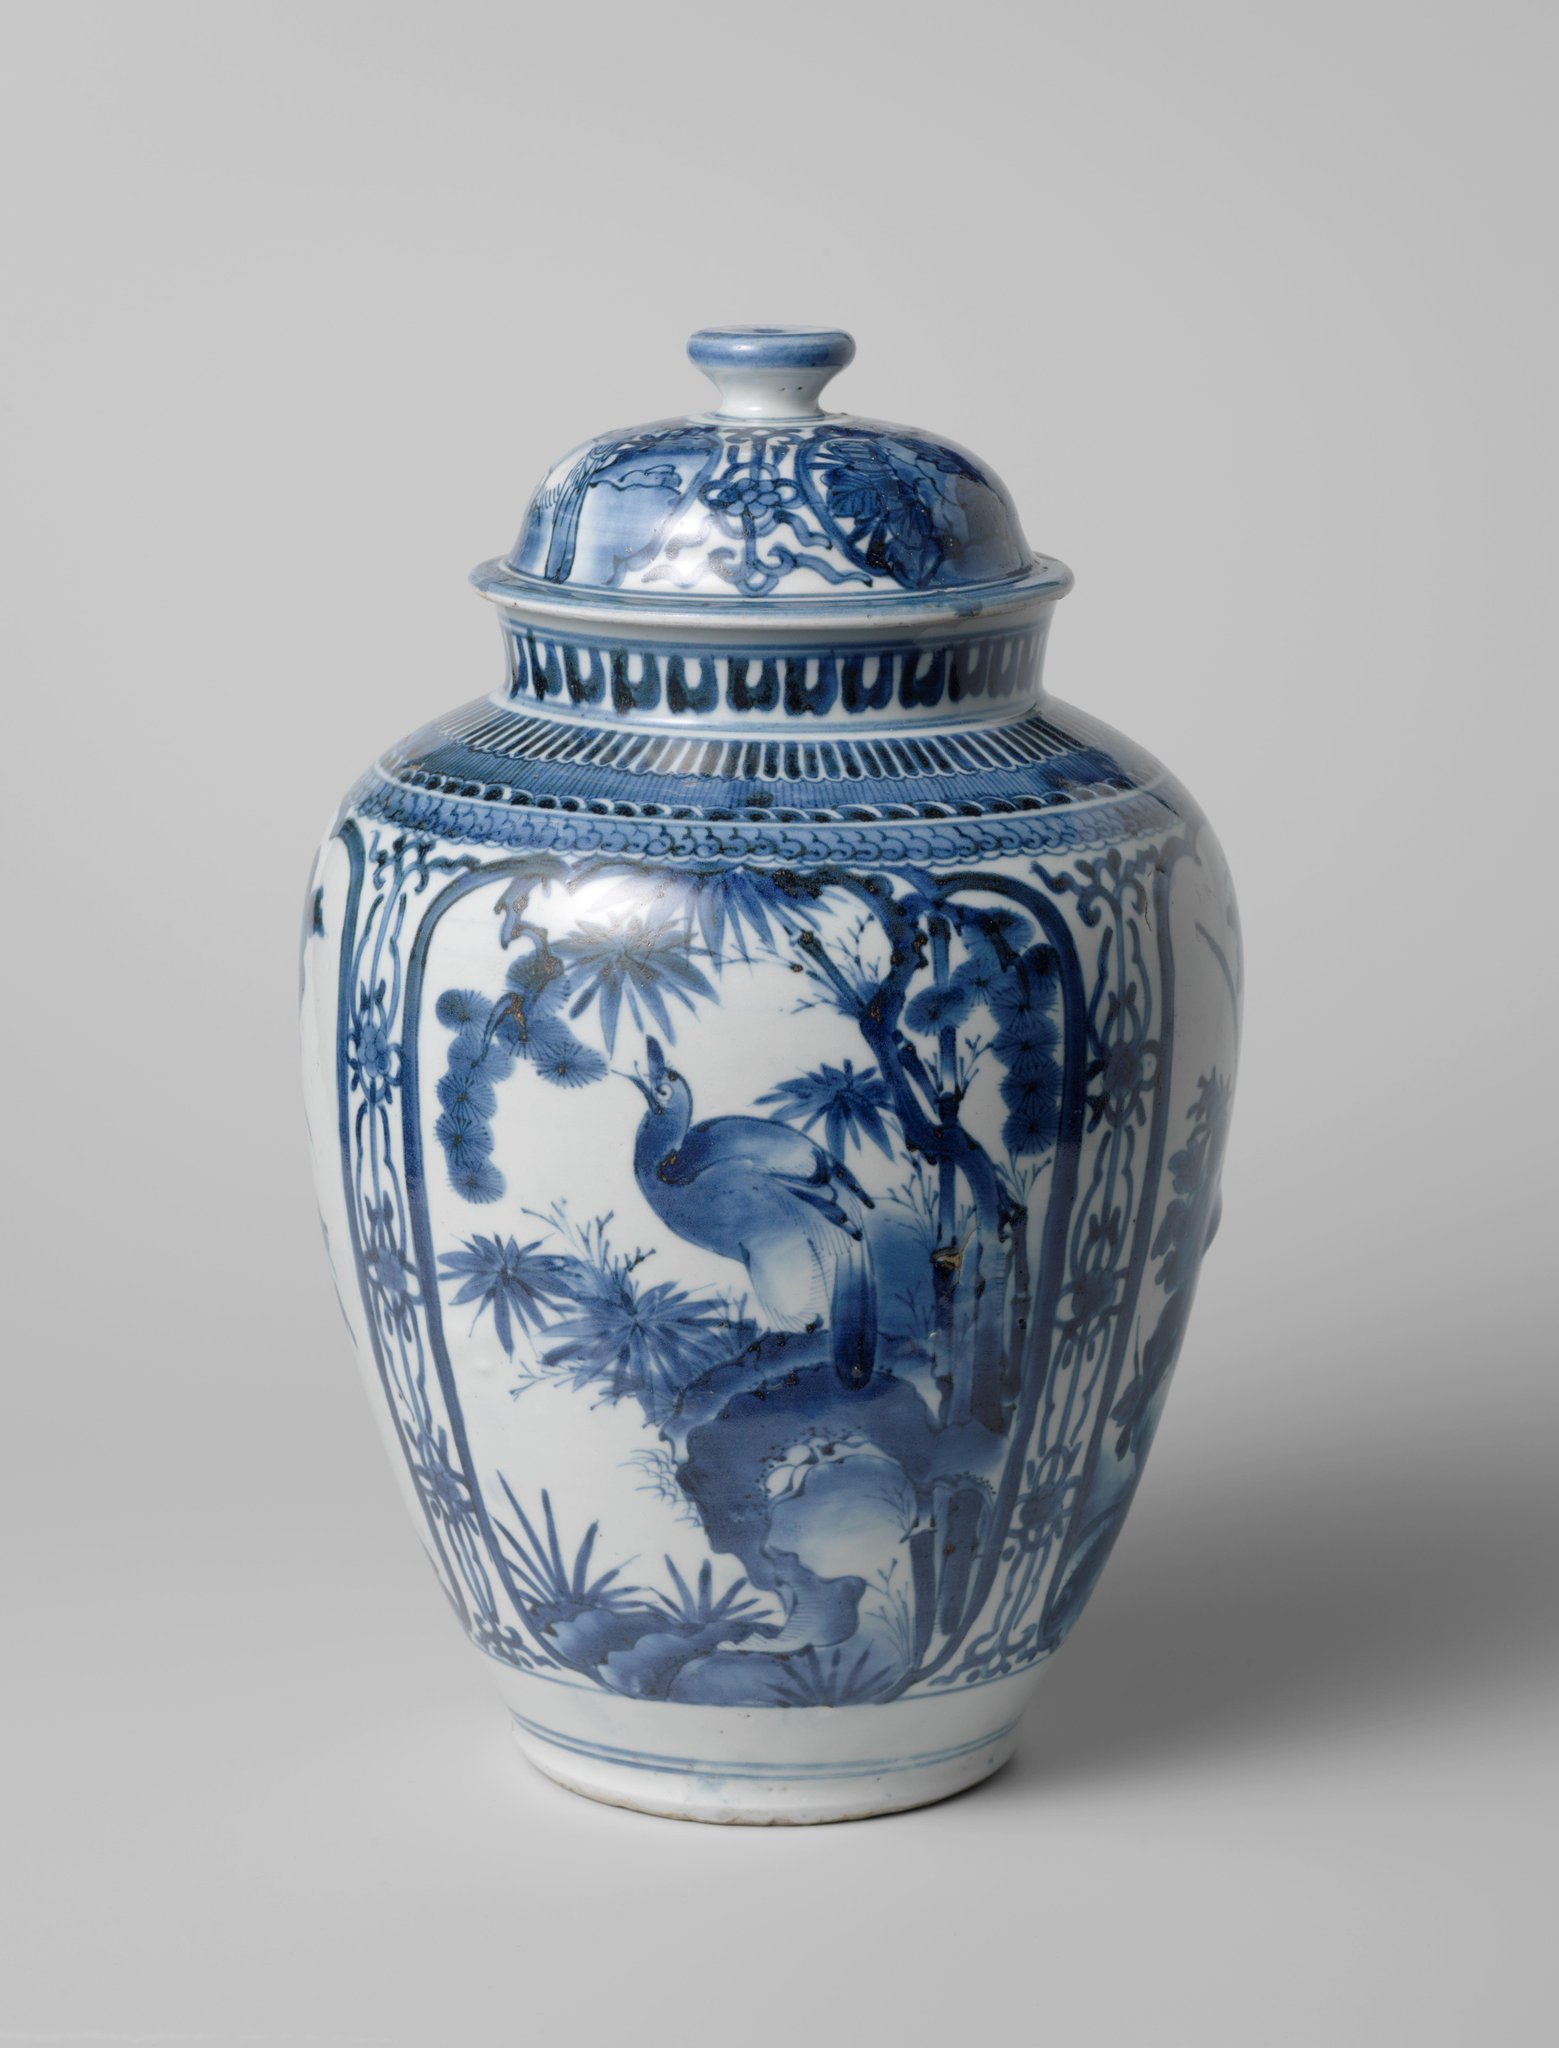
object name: pot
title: Ovoid covered jar with a bird on a rock and flowering plants in panels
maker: Anonymous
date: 1650-1680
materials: cobalt, glaze, paint, porcelain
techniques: firing, turning, vitrification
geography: japan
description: Eivormige dekselpot van porselein, beschilderd in onderglazuur blauw. Op de buik vier geschulpte cartouches met in twee een vogel op een rots bij planten (pijnboom, bamboe), in de andere twee een bloeiende plant (pioen) bij een rots. Tussen de cartouches gestileerde bloemranken. Op de schouder en de hals een decoratieve band. Blauw-wit.